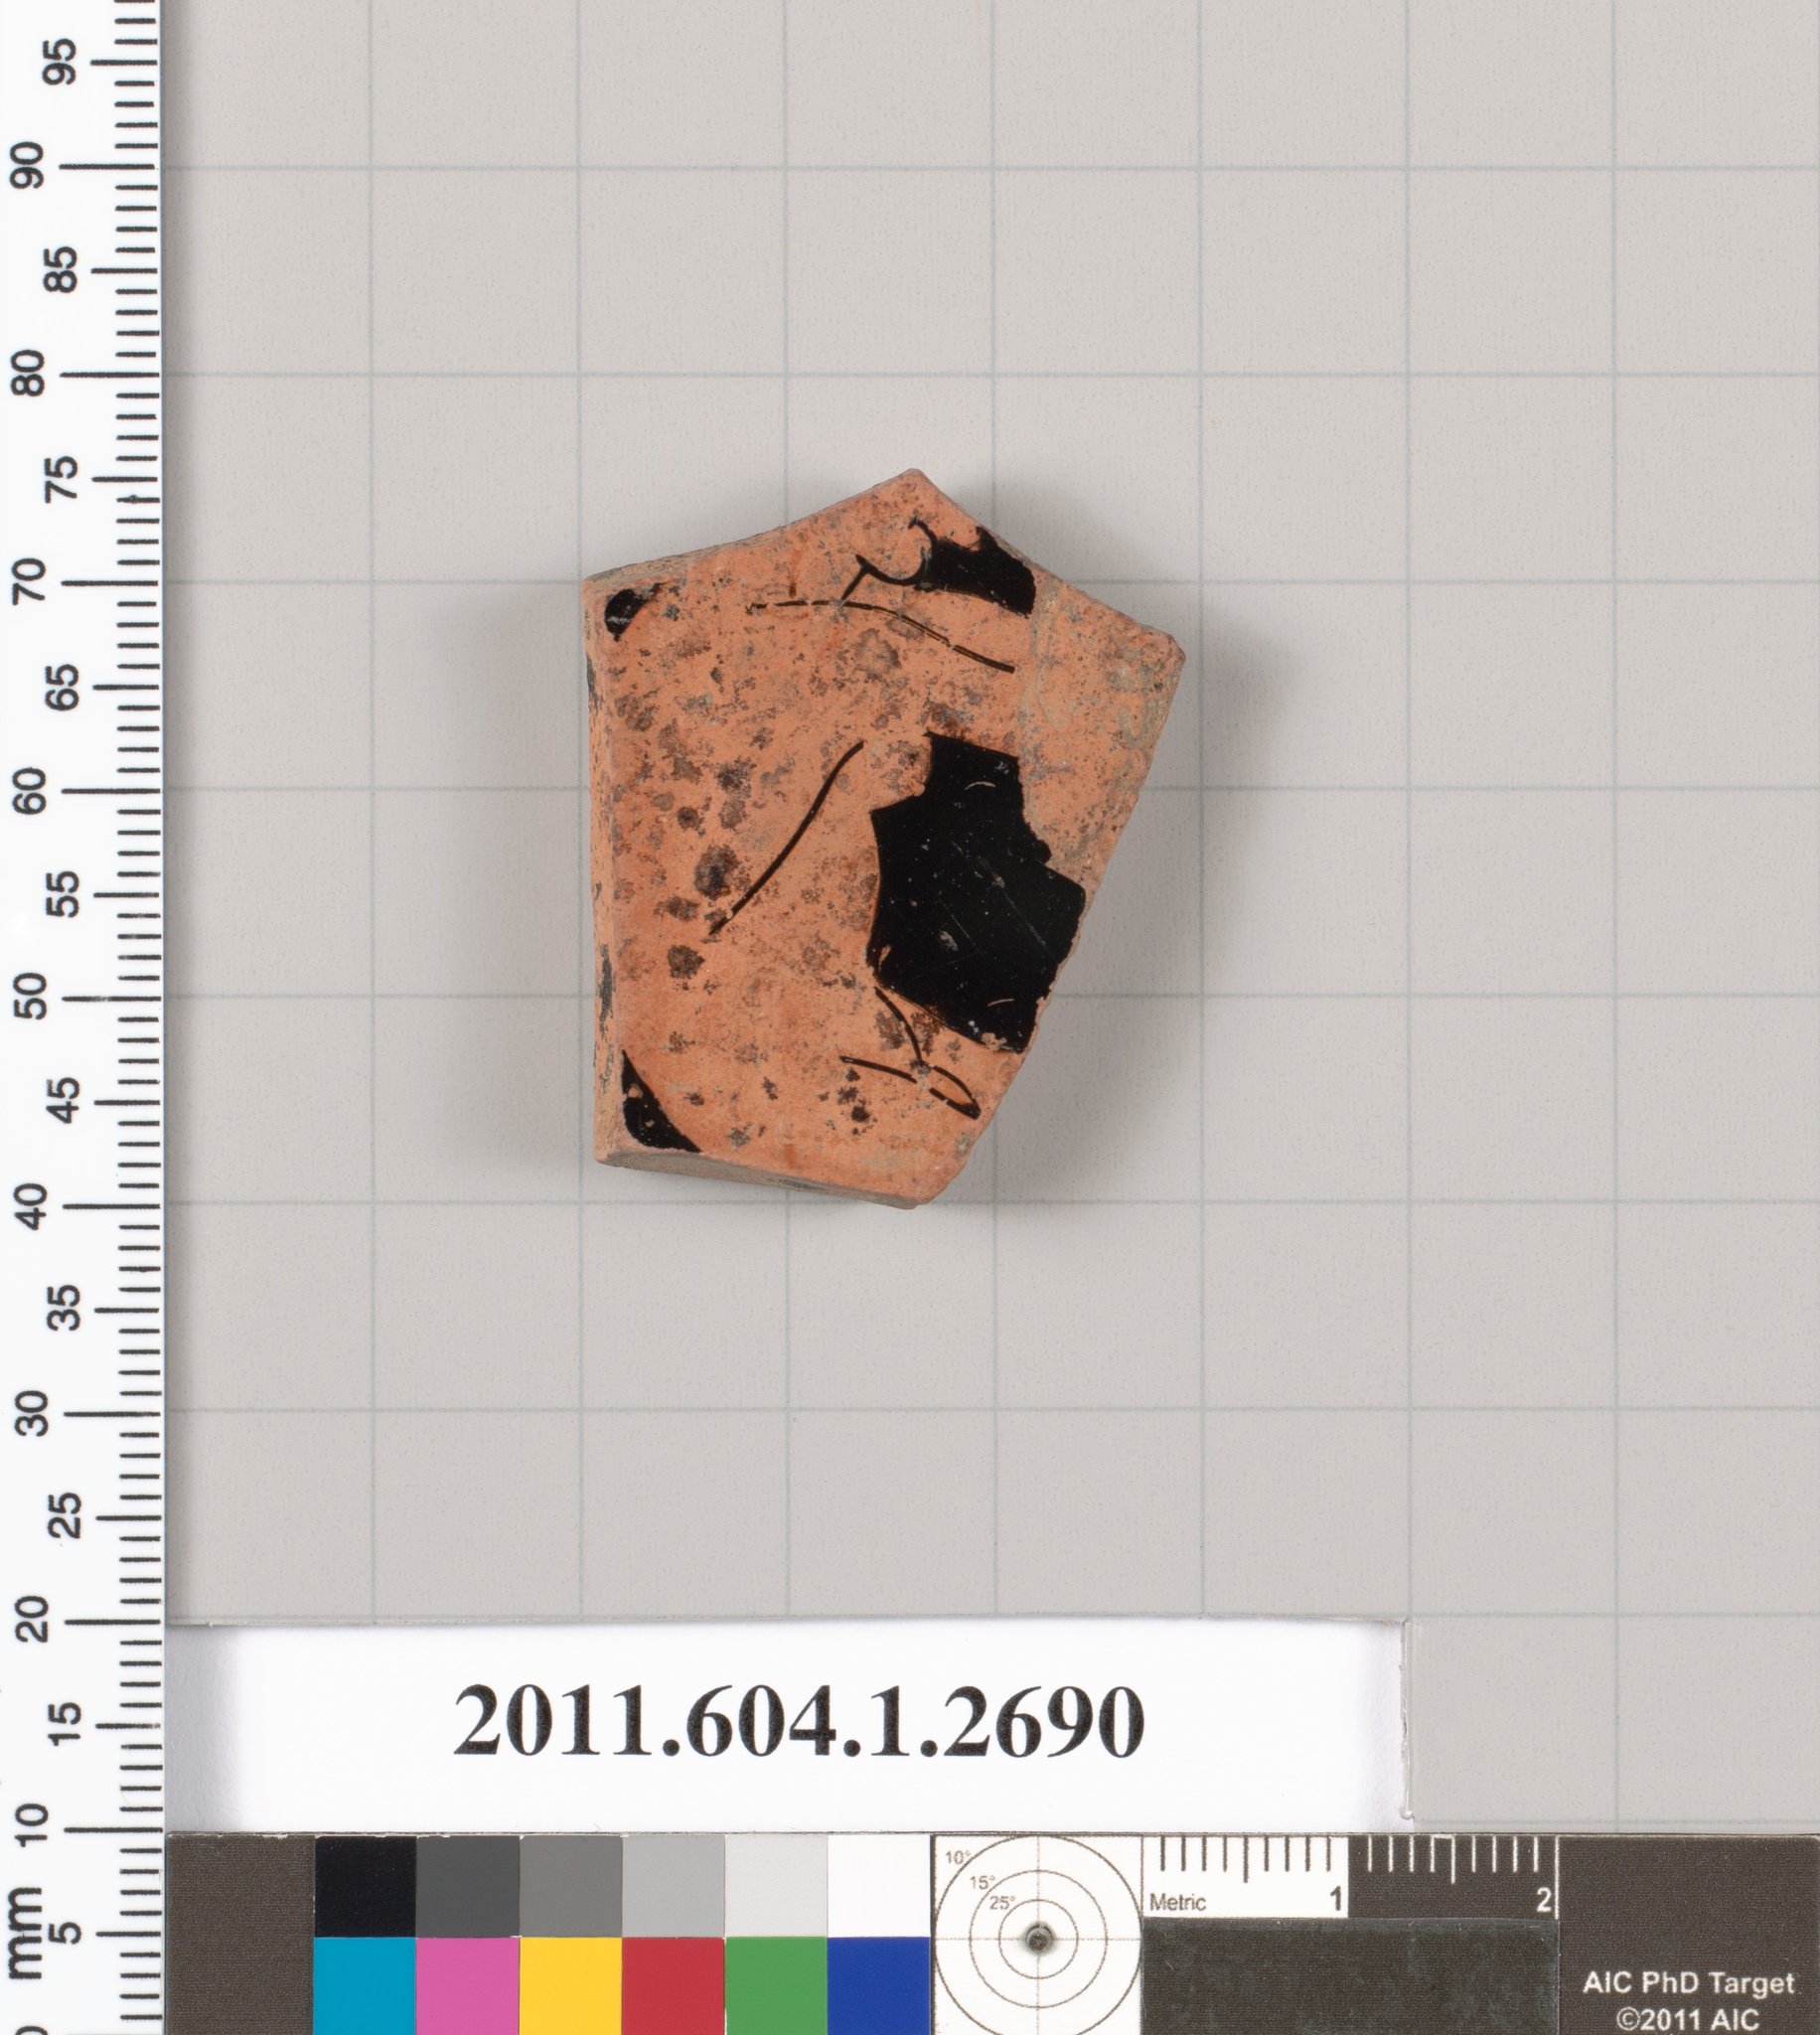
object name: kylix fragment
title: Terracotta fragment of a kylix (drinking cup)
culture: greek, attic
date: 500-490 BCE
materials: terracotta